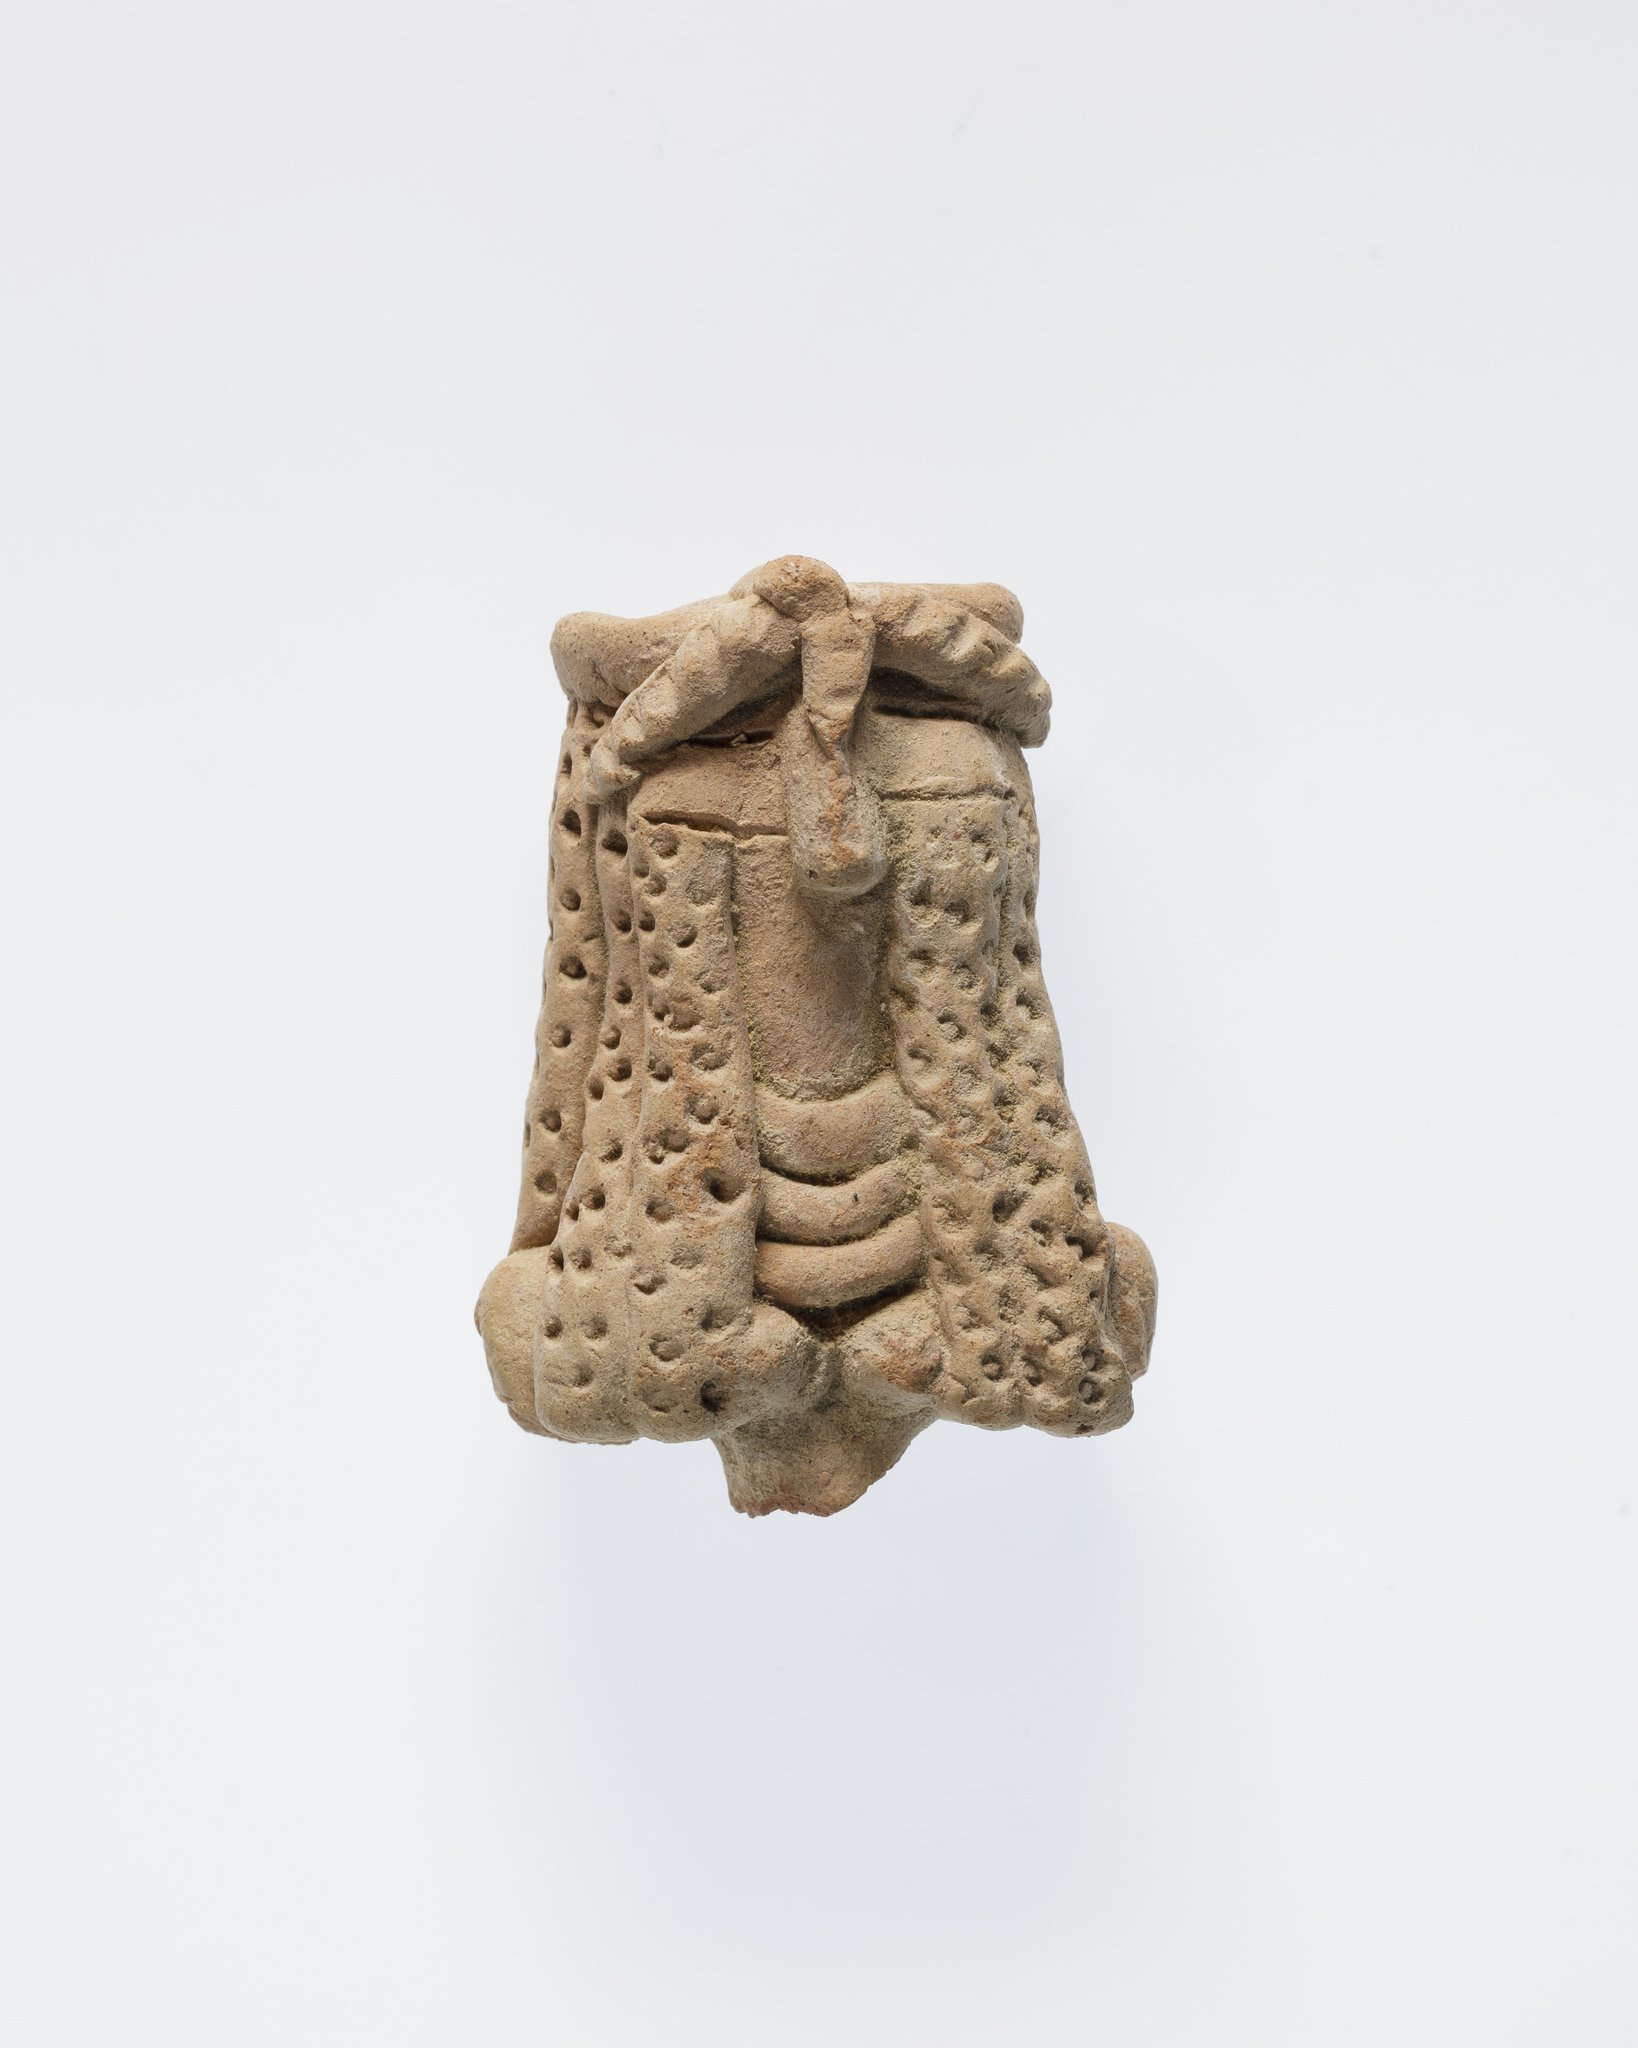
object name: statuette, female head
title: Head from a figurine of a Woman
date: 1460-1295 BCE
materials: pottery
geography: egypt